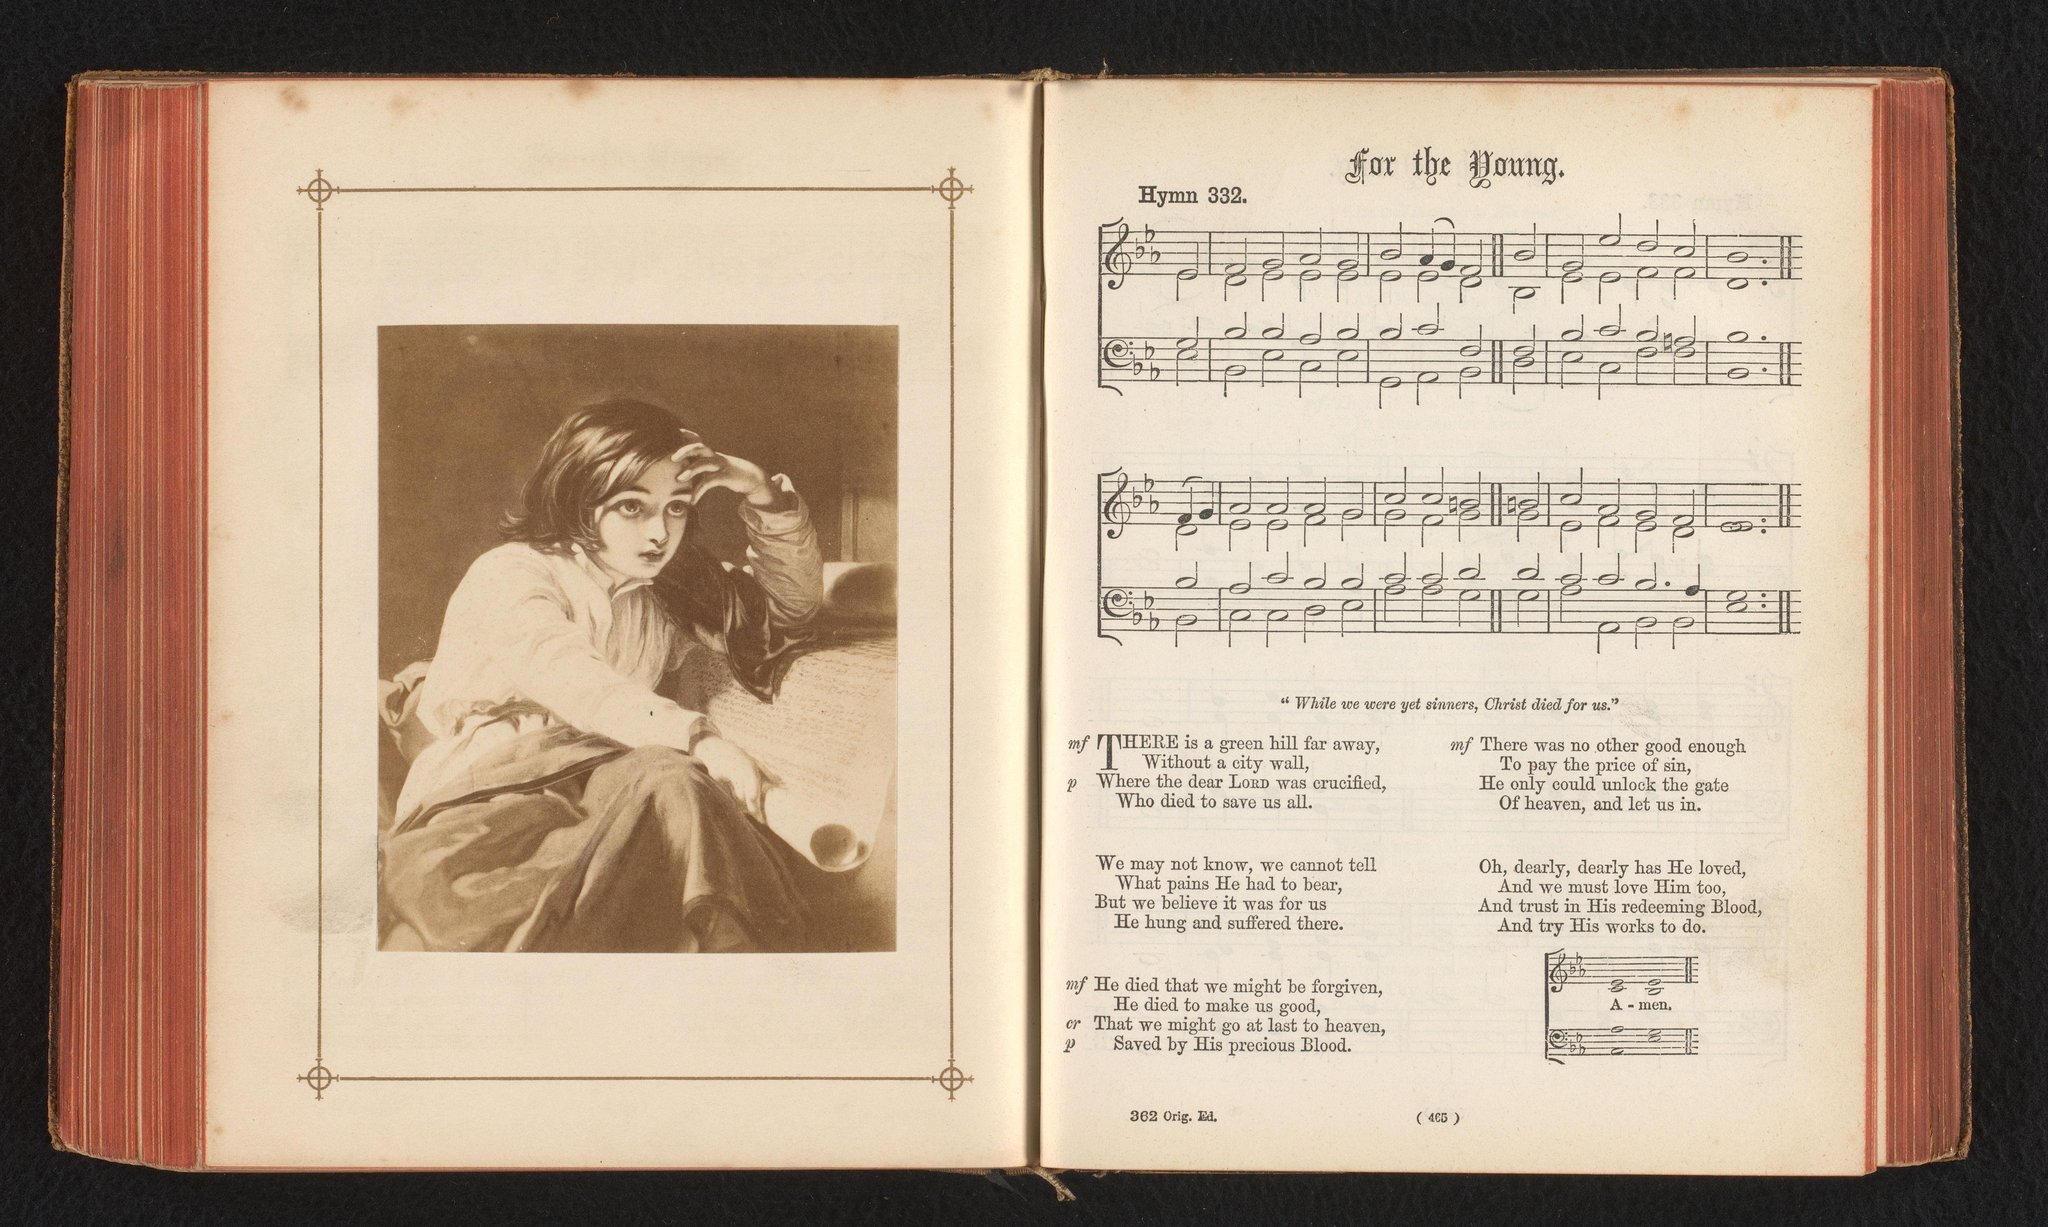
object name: reproduction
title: Fotoreproductie van een schilderij van jongen met boekrol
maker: Anonymous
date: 1866-1876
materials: paper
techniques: albumen print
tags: ecclesiastical books, scrolls, etc., picture, painting